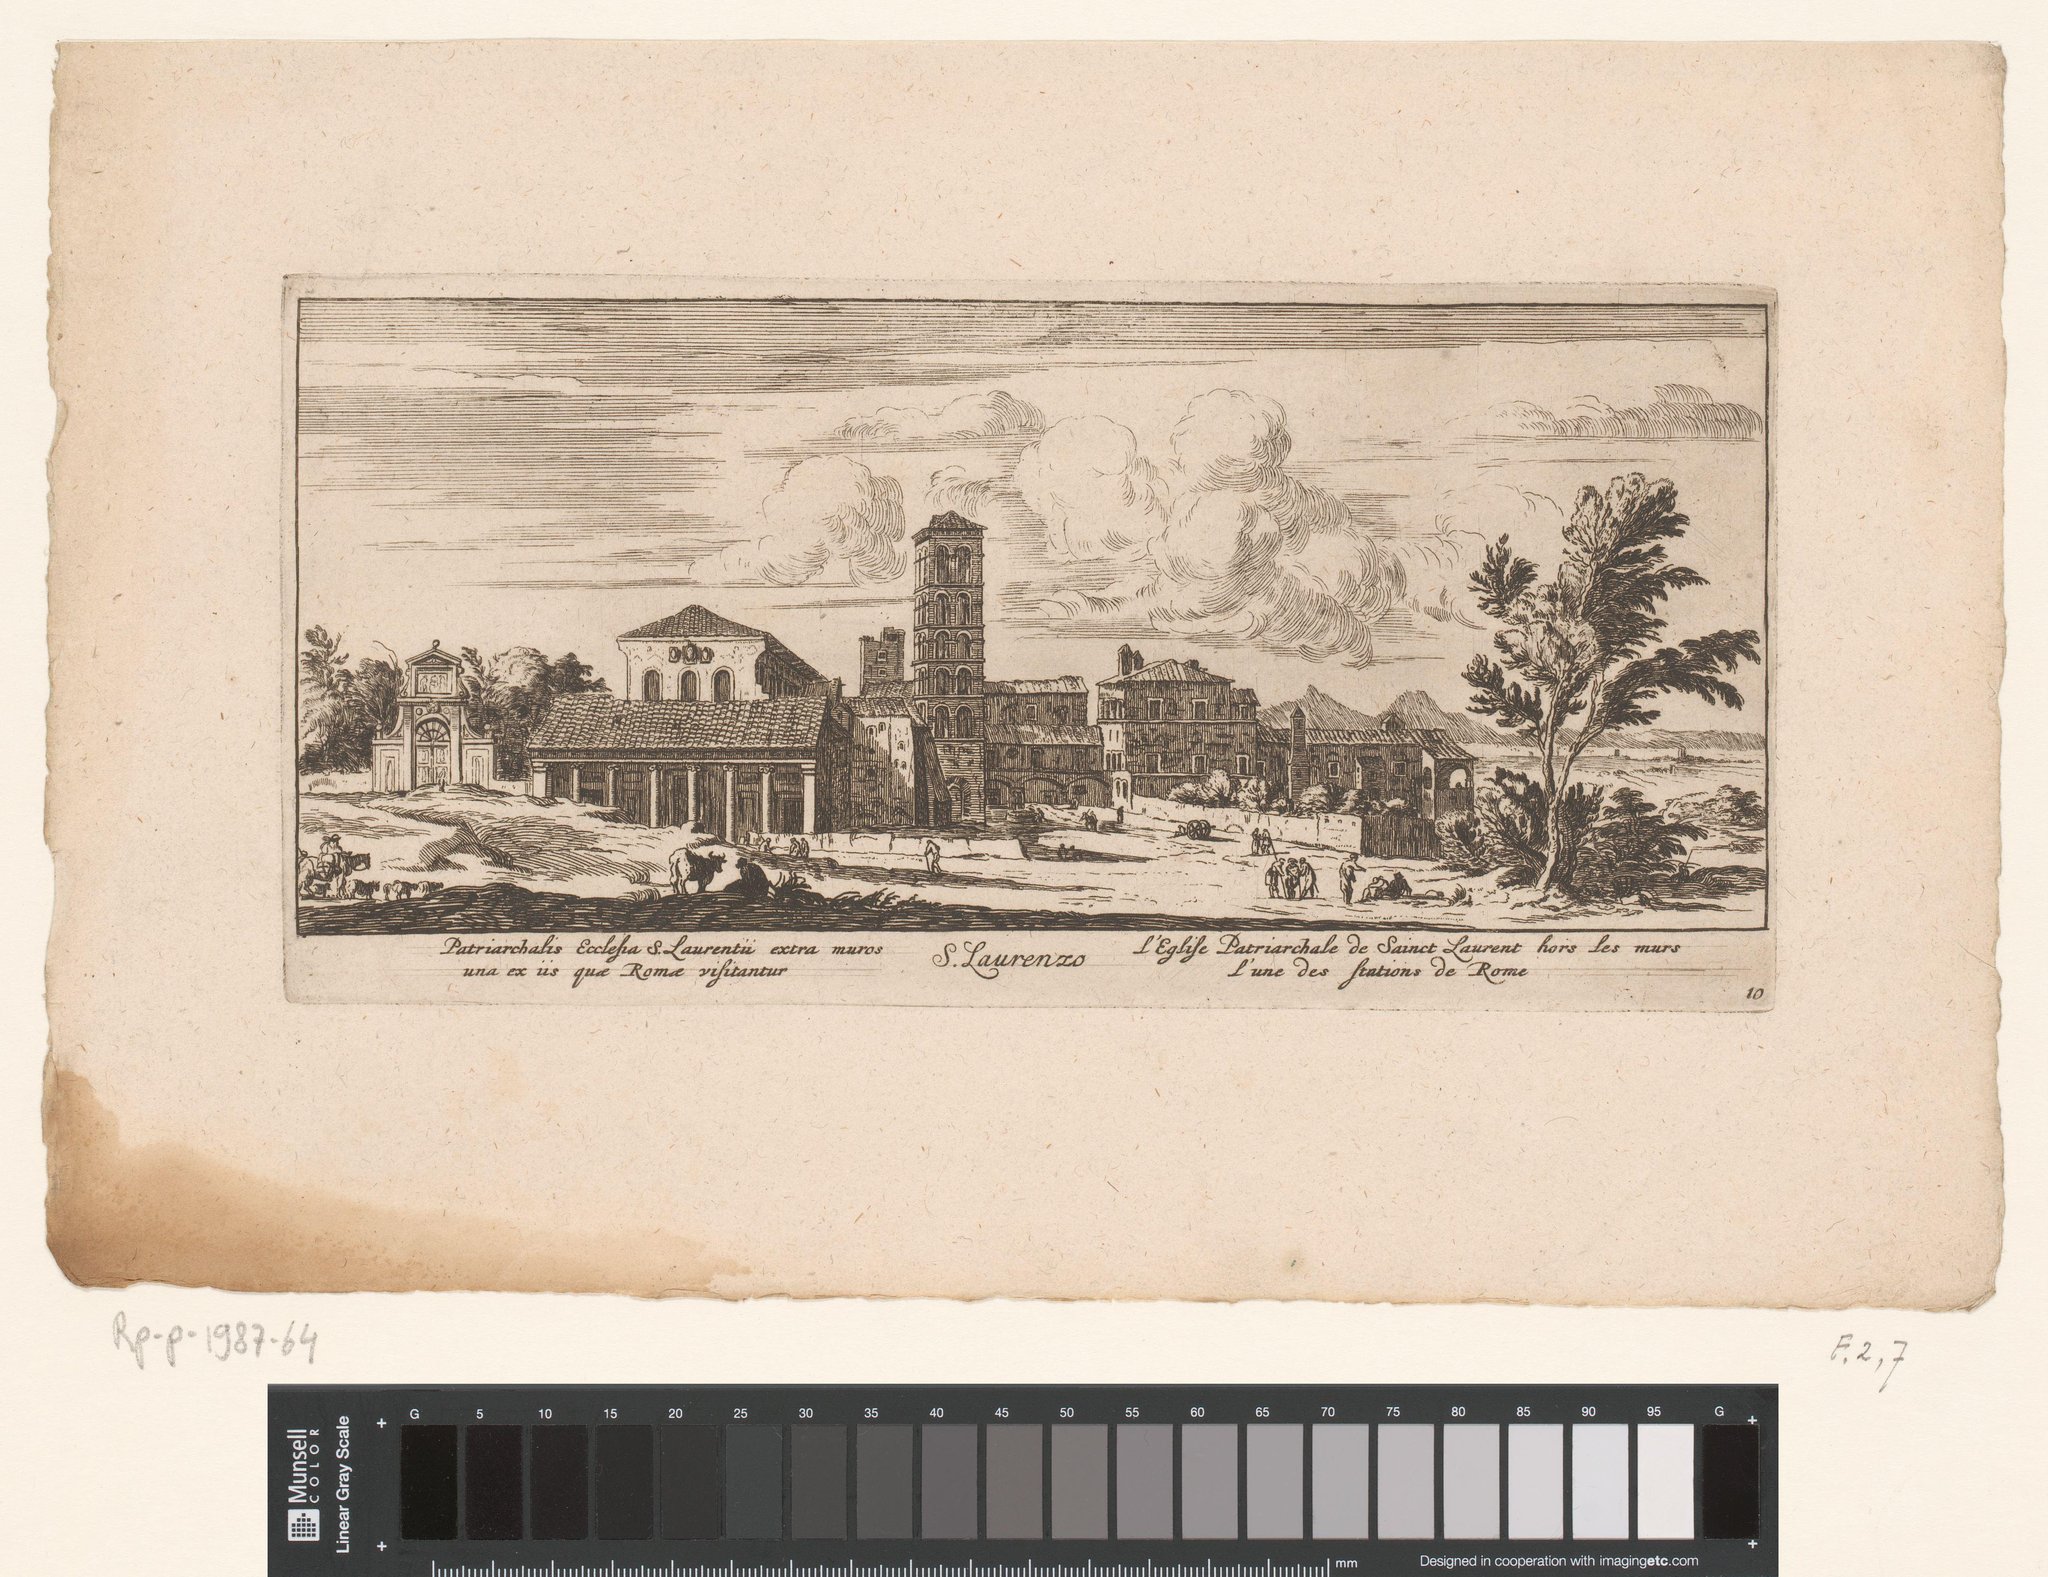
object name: print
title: S. Laurenzo / Patriarchalis Exxlesia S. Laurentii extra muros (...) / L'Eglise Patriarchale de Sainct Laurent hoir les murs (...)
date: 1648-1712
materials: paper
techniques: etching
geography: amsterdam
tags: tower, clock tower ~ monumental adornment, church (exterior)